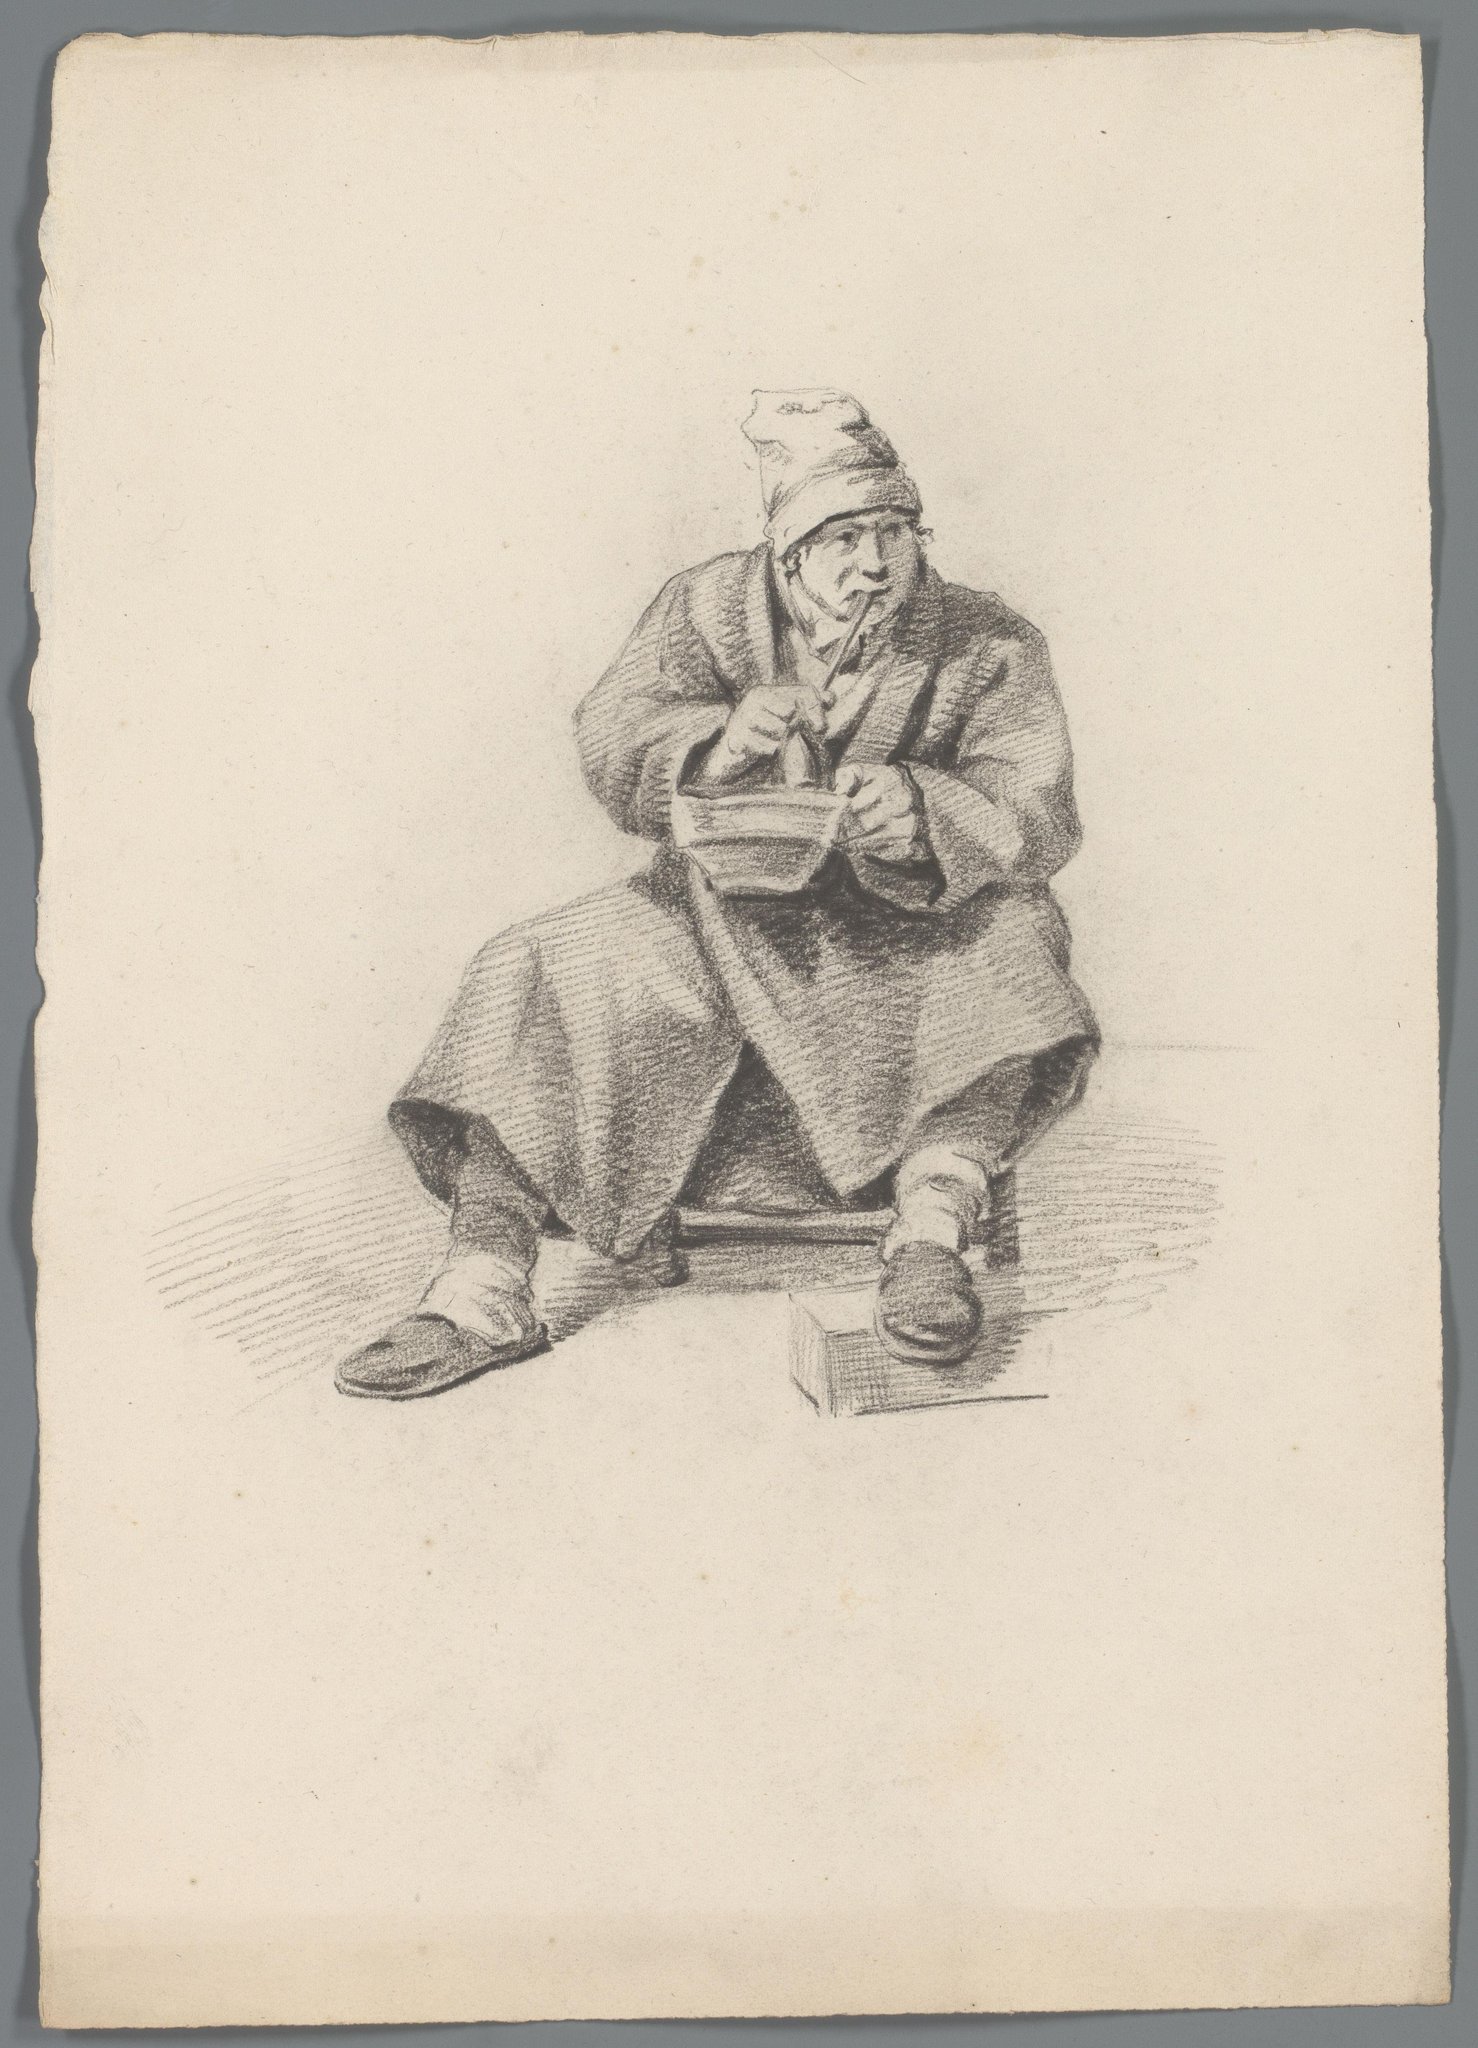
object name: drawing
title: Zittende man met pijp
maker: Anonymous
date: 1820-1830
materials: chalk, paper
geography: the hague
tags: sitting figure, adult man, pipe ~ tobacco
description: Tekeningen waarschijnlijk ontstaan bij het Haagse kunstgenootschap ‘Tot Nut der Tekenkunst’, waar twee keer per week tekenavonden werden georganiseerd met geklede modellen.